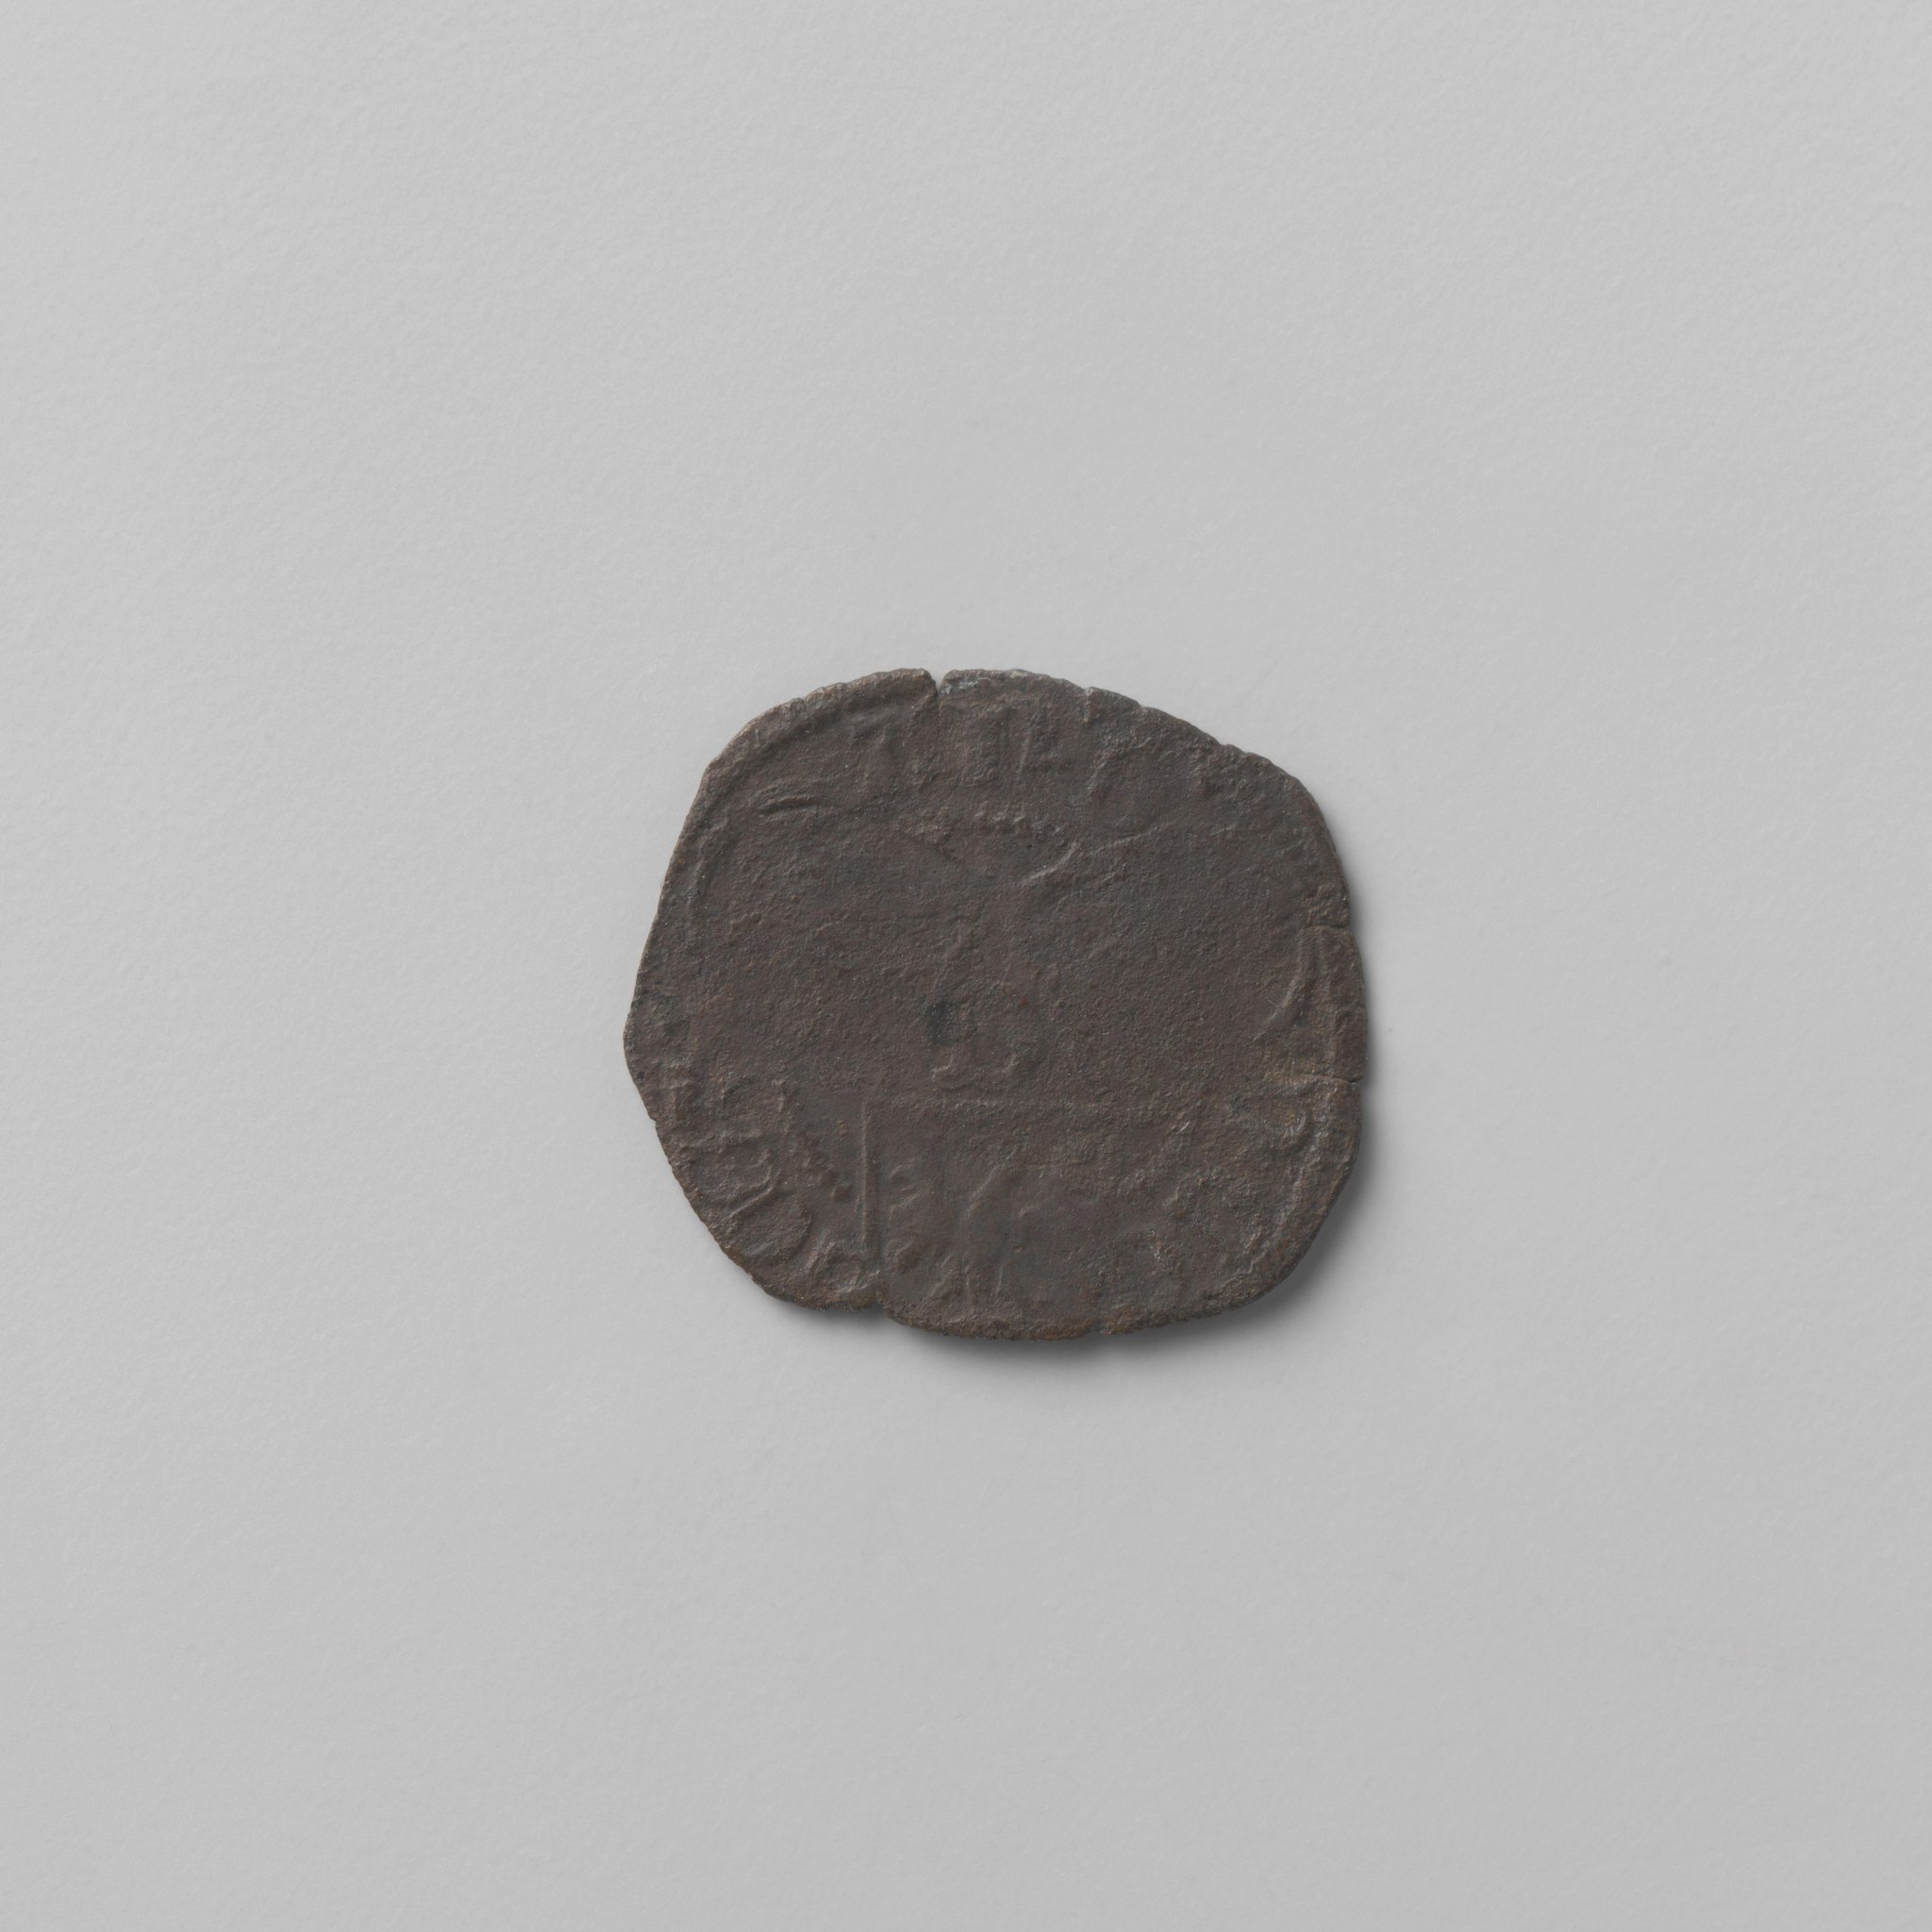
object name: coin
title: Halve plak van de Drie Steden, 1575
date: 1575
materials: silver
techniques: striking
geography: deventer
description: Koper-zilveren munt. Voorzijde: versierd lang kruis. In het centrum een ster. Keerzijde: wapenschilden van de Drie Steden, in het centrum letter D. Jaartal in omschrift.